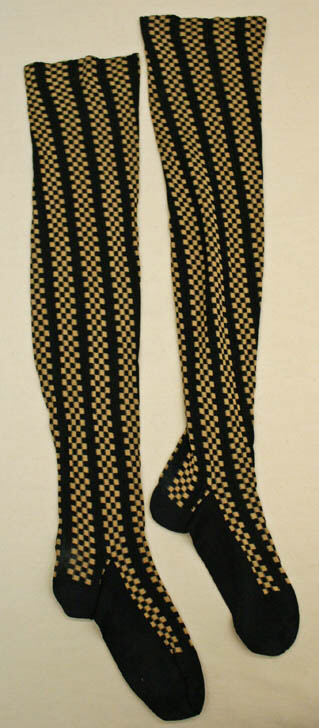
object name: stocking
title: Stockings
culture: american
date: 1867-1900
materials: cotton